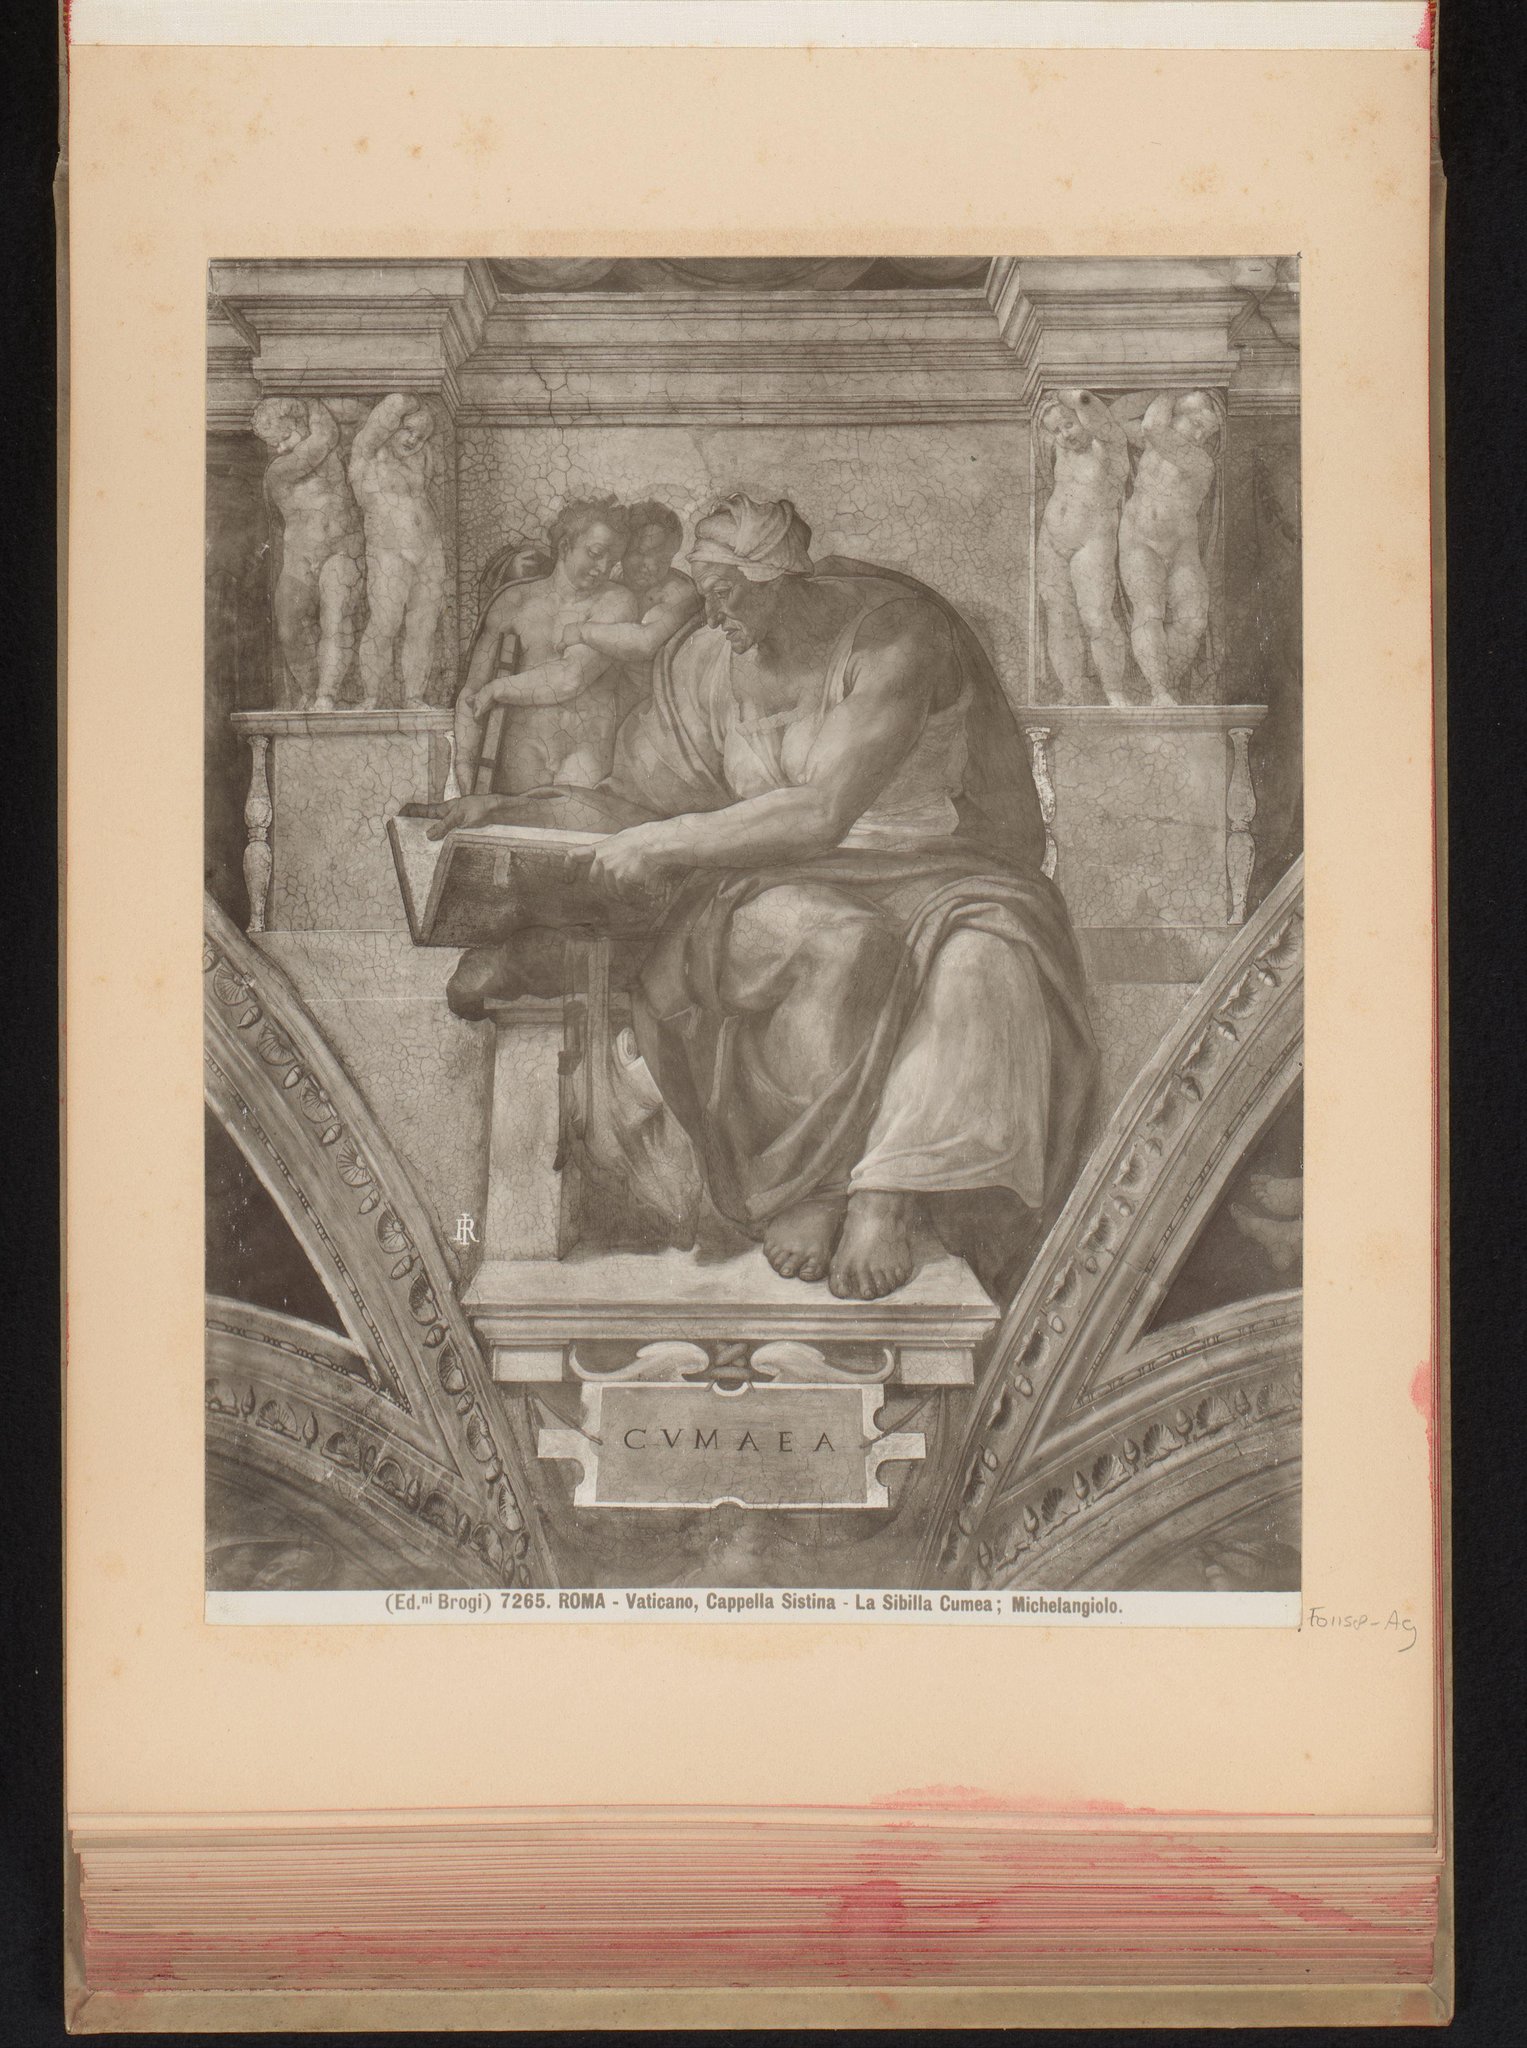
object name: photograph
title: Roma - Vaticano, Cappella Sistina - La Sibilla Cumea; Michelangiolo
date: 1875-1907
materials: photographic support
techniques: gelatin silver print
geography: vatican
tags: cumaean sibyl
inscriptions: number: ‘7265’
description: Onderdeel van Fotoalbum met opnames van bezienswaardigheden en kunstwerken in Italië.